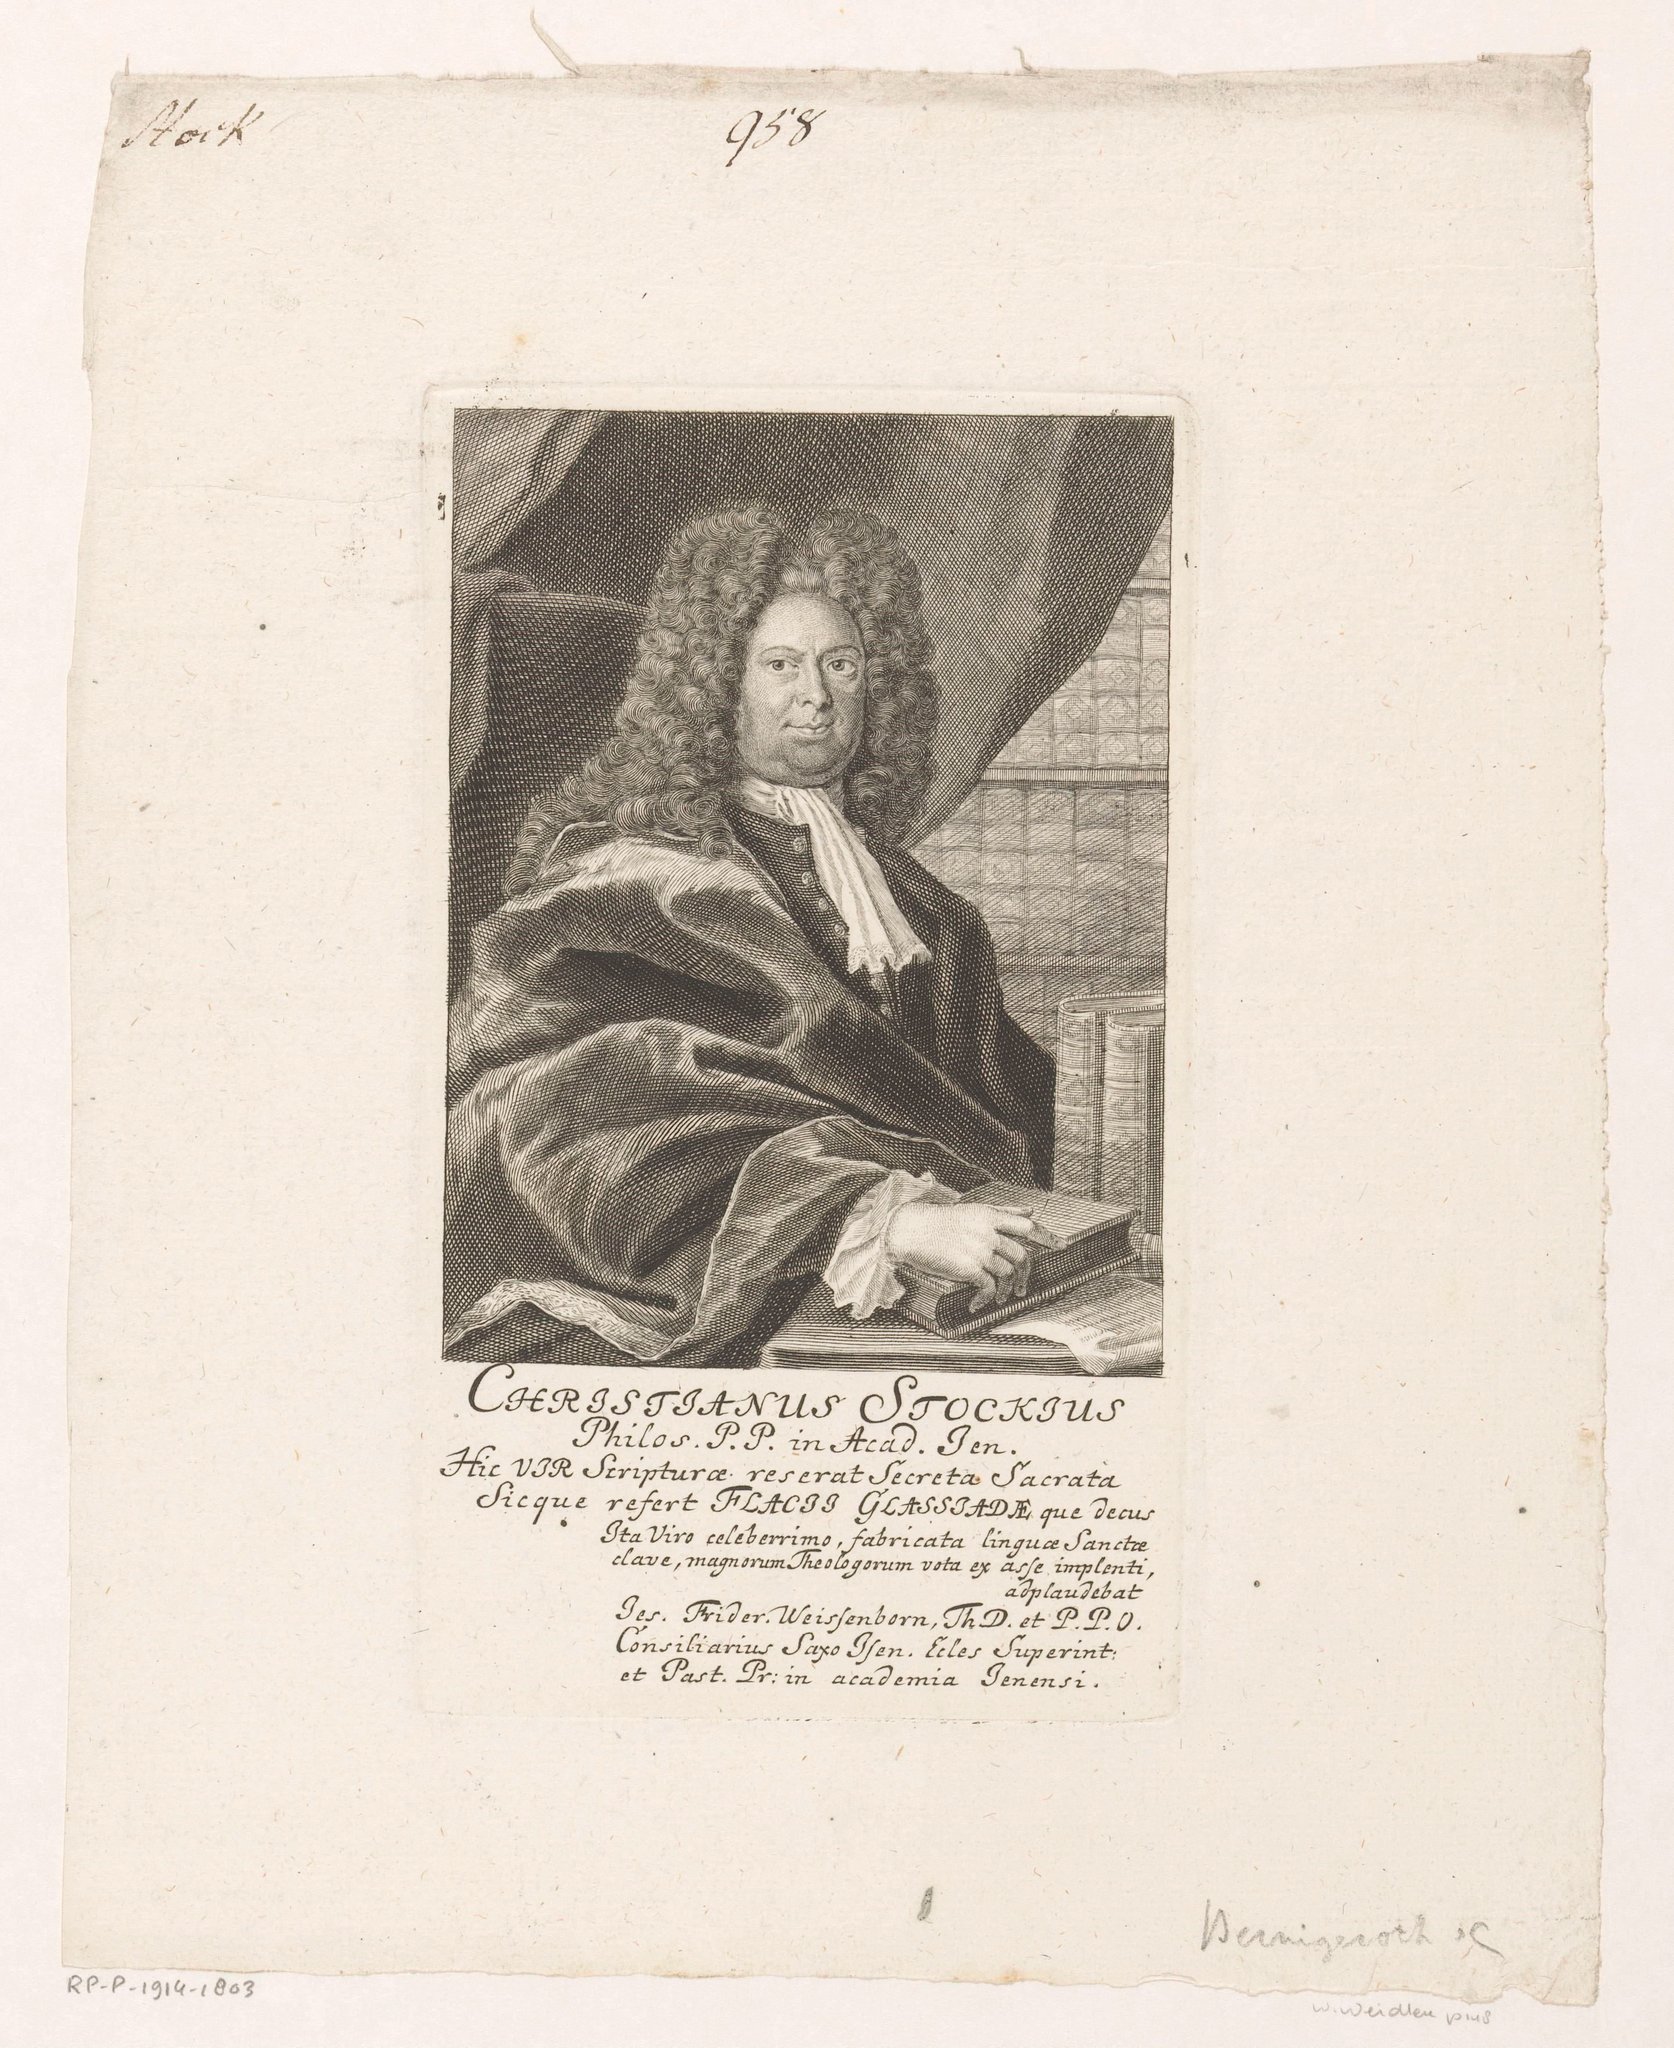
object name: print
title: Portret van Christian Stock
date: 1731-1733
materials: paper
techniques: engraving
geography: leipzig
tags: christian stock, bookshelves, historical persons, book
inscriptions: collector's mark: Lugt 2228